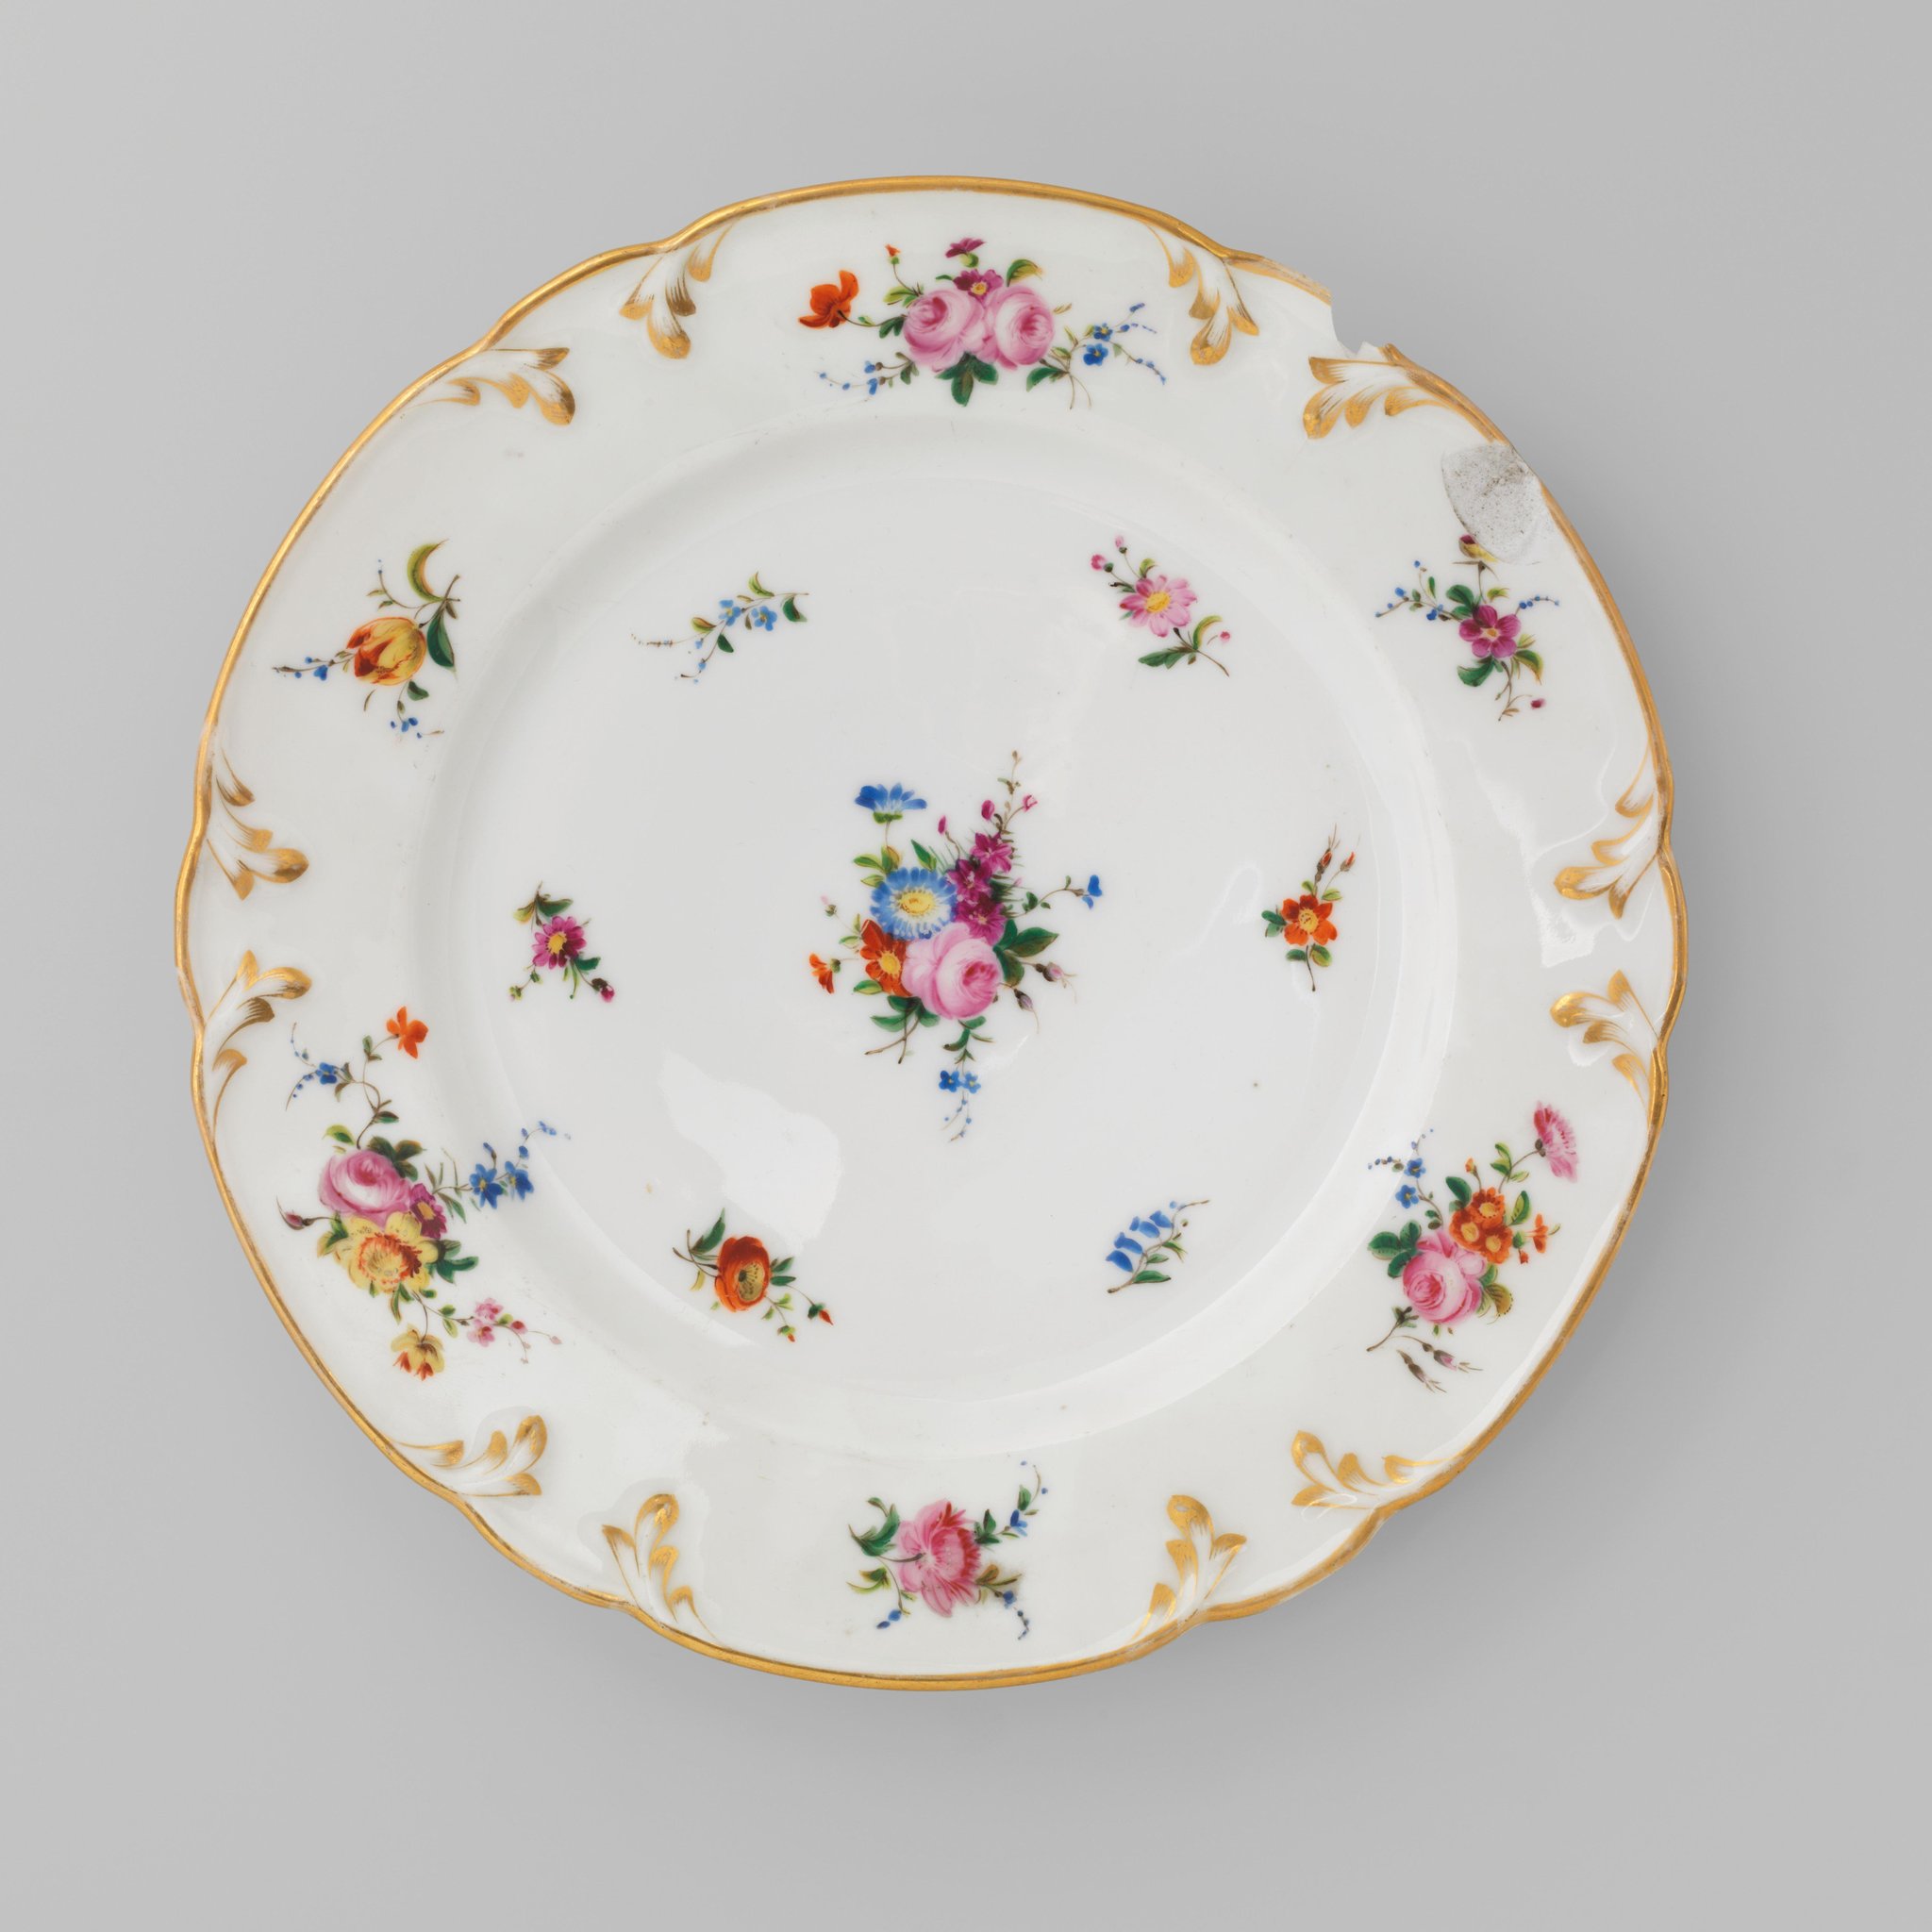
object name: plate dish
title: Plate with bouquets and flower sprays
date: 1839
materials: glaze, gold, paint, porcelain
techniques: firing, forming, gilding, turning, vitrification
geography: paris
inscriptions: mark: ‘3/ I’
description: Bord van porselein met een gelobde rand, beschilderd op het glazuur in blauw, rood, roze, groen, geel, paars, zwart en goud. Op het plat boeketten van verschillende bloemen en strooibloemen. Vanuit de gelobde, gouden rand, gemodelleerde bladranken in reliëf, aangezet met goud. Hiertussen boeketten. Drie proenen op de onderzijde. Gemerkt op de onderzijde met 3 en I. Rand beschadigd.